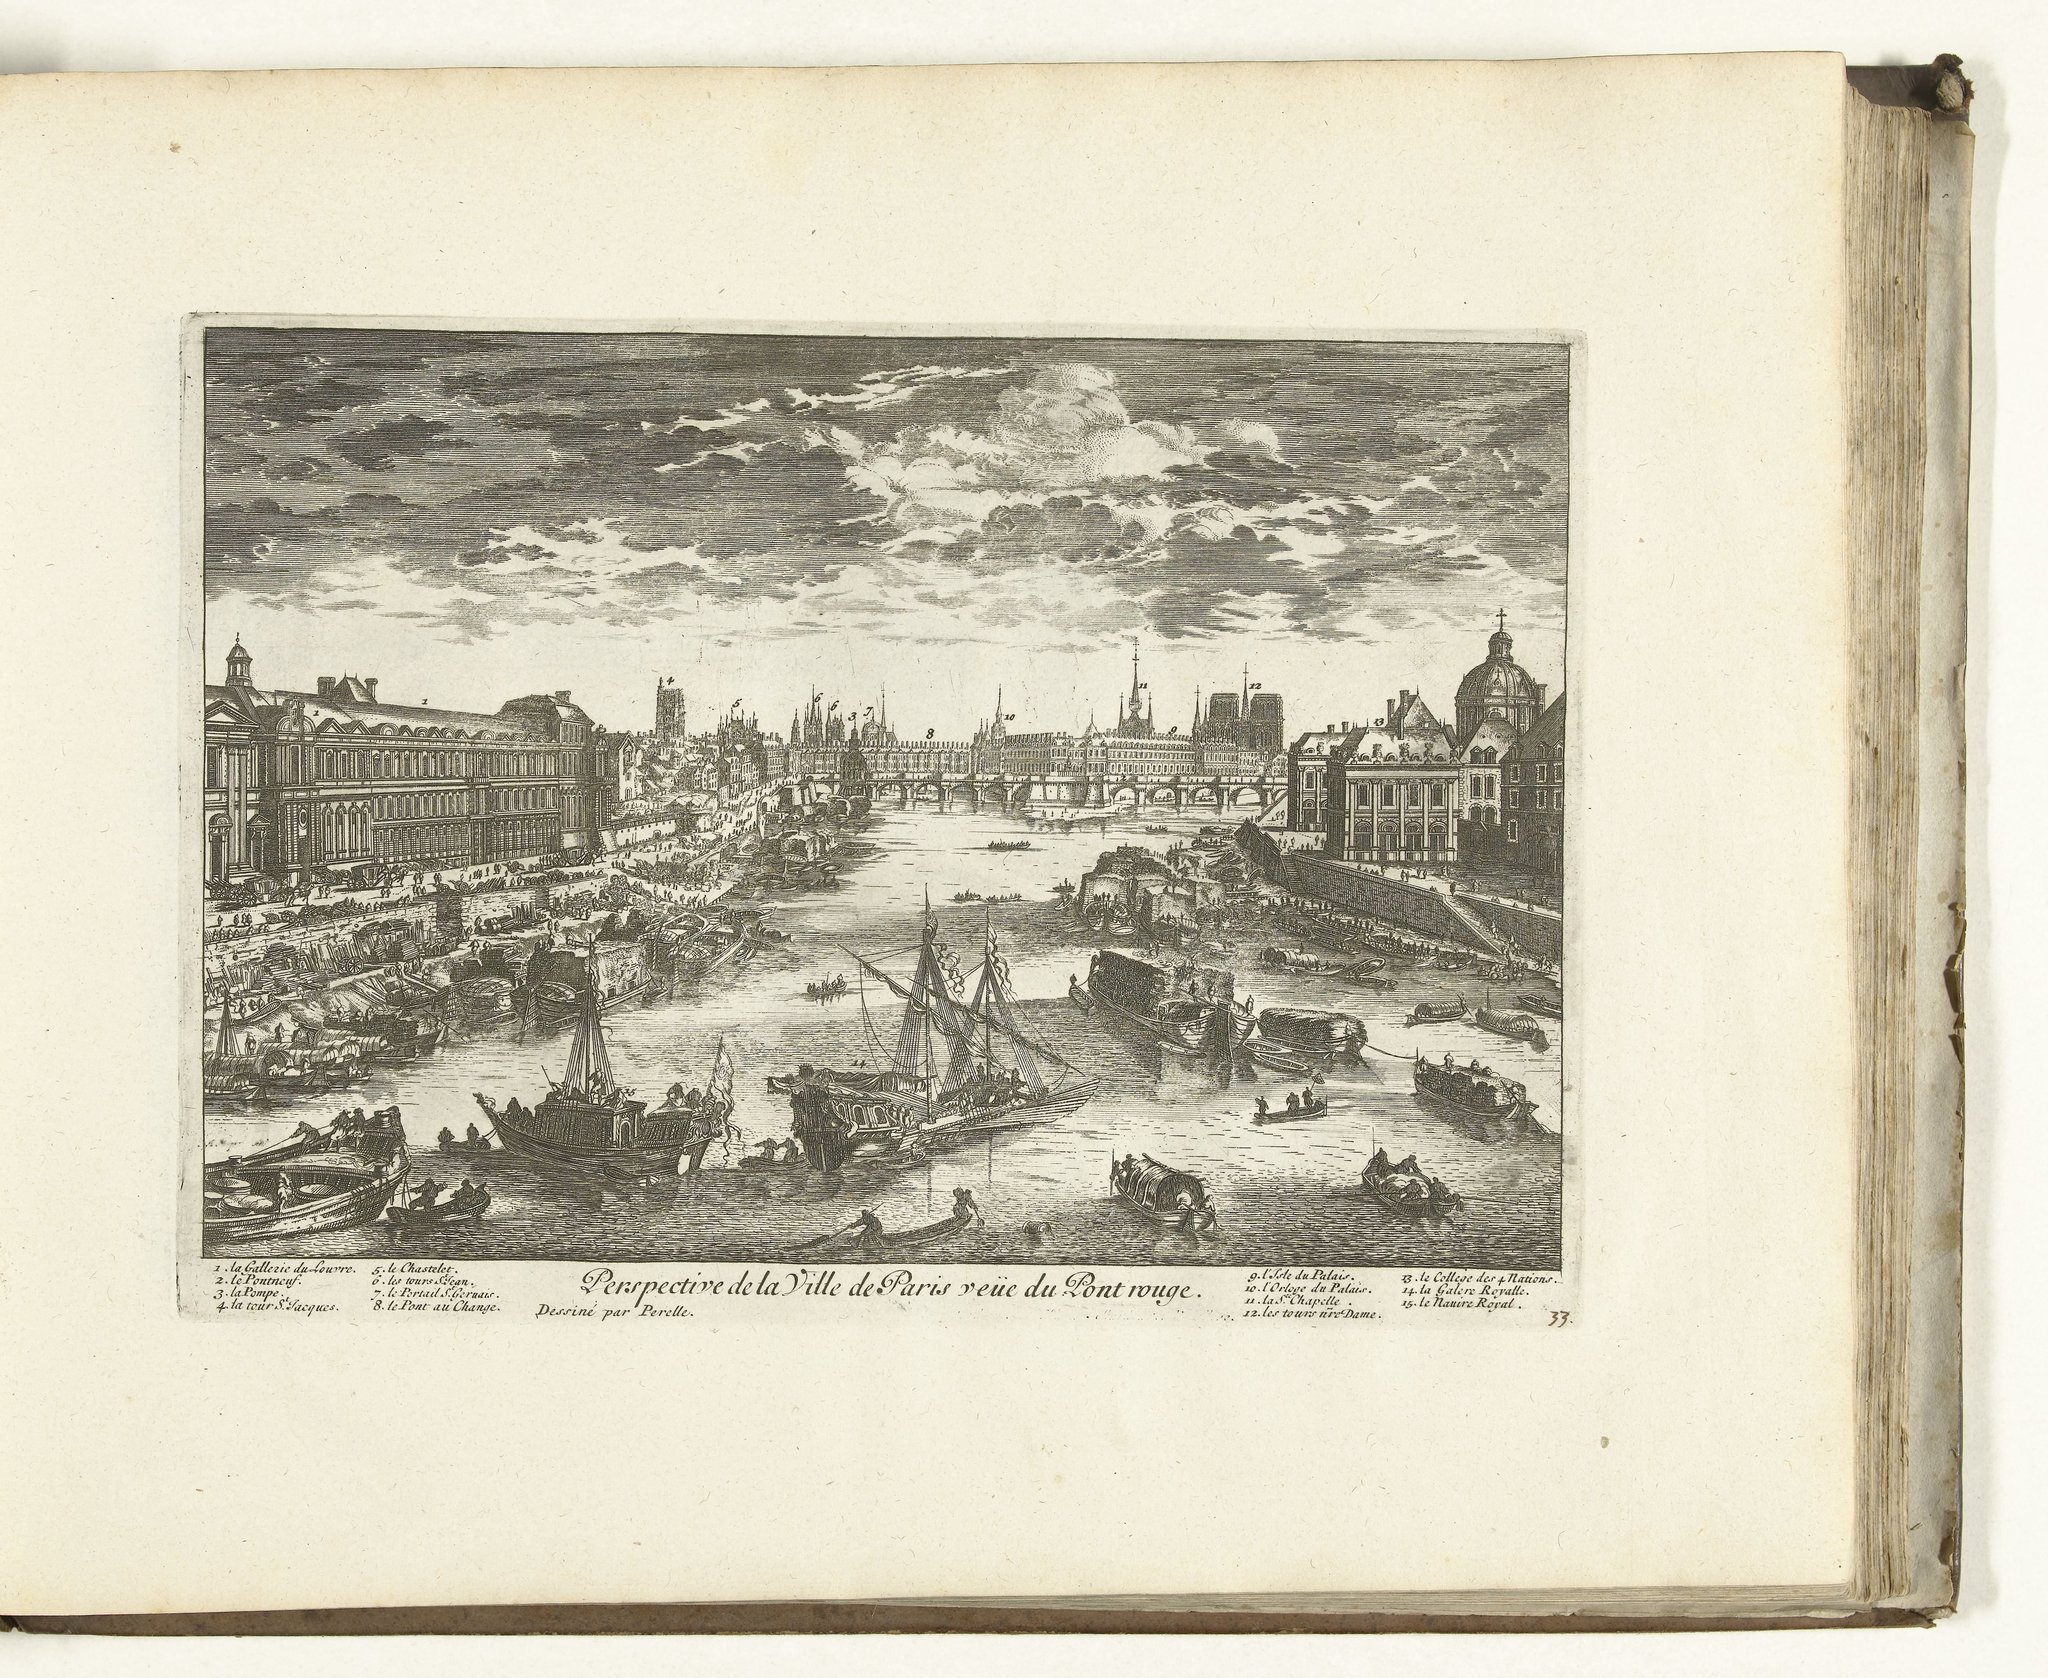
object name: print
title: Les Forces de l'Europe, Asie, Afrique et Amerique (...) Comme aussi les Cartes des Côtes de France et d'Espagne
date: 1726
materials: paper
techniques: engraving, etching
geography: northern netherlands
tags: paris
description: Gezicht op Parijs en de Seine gezien vanaf de Pont Rouge (Pont-Royal). Plaat nr. 33 in deel II van het prentwerk: Les Forces de l'Europe, Asie, Afrique et Amerique ... Comme aussi les Cartes des Côtes de France et d'Espagne uit 1726, dit eerste deel met 238 met de hand genummerde platen van vermaarde sterke steden en vestingen in het kader van de Spaanse Successieoorlog 1701-1713. Voor het merendeel zijn deze platen gekopieerd naar de anonieme Franse platen van vermaarde sterke steden en vestingen: in Les forces de l'Europe en in: Le theatre de la guerre, dans les Pays-Bas, beide oorspronkelijk uitgegeven door Nicolas de Fer te Parijs (1693-1697) in het kader van de Negenjarige Oorlog. Titel en opschriften in het Frans.